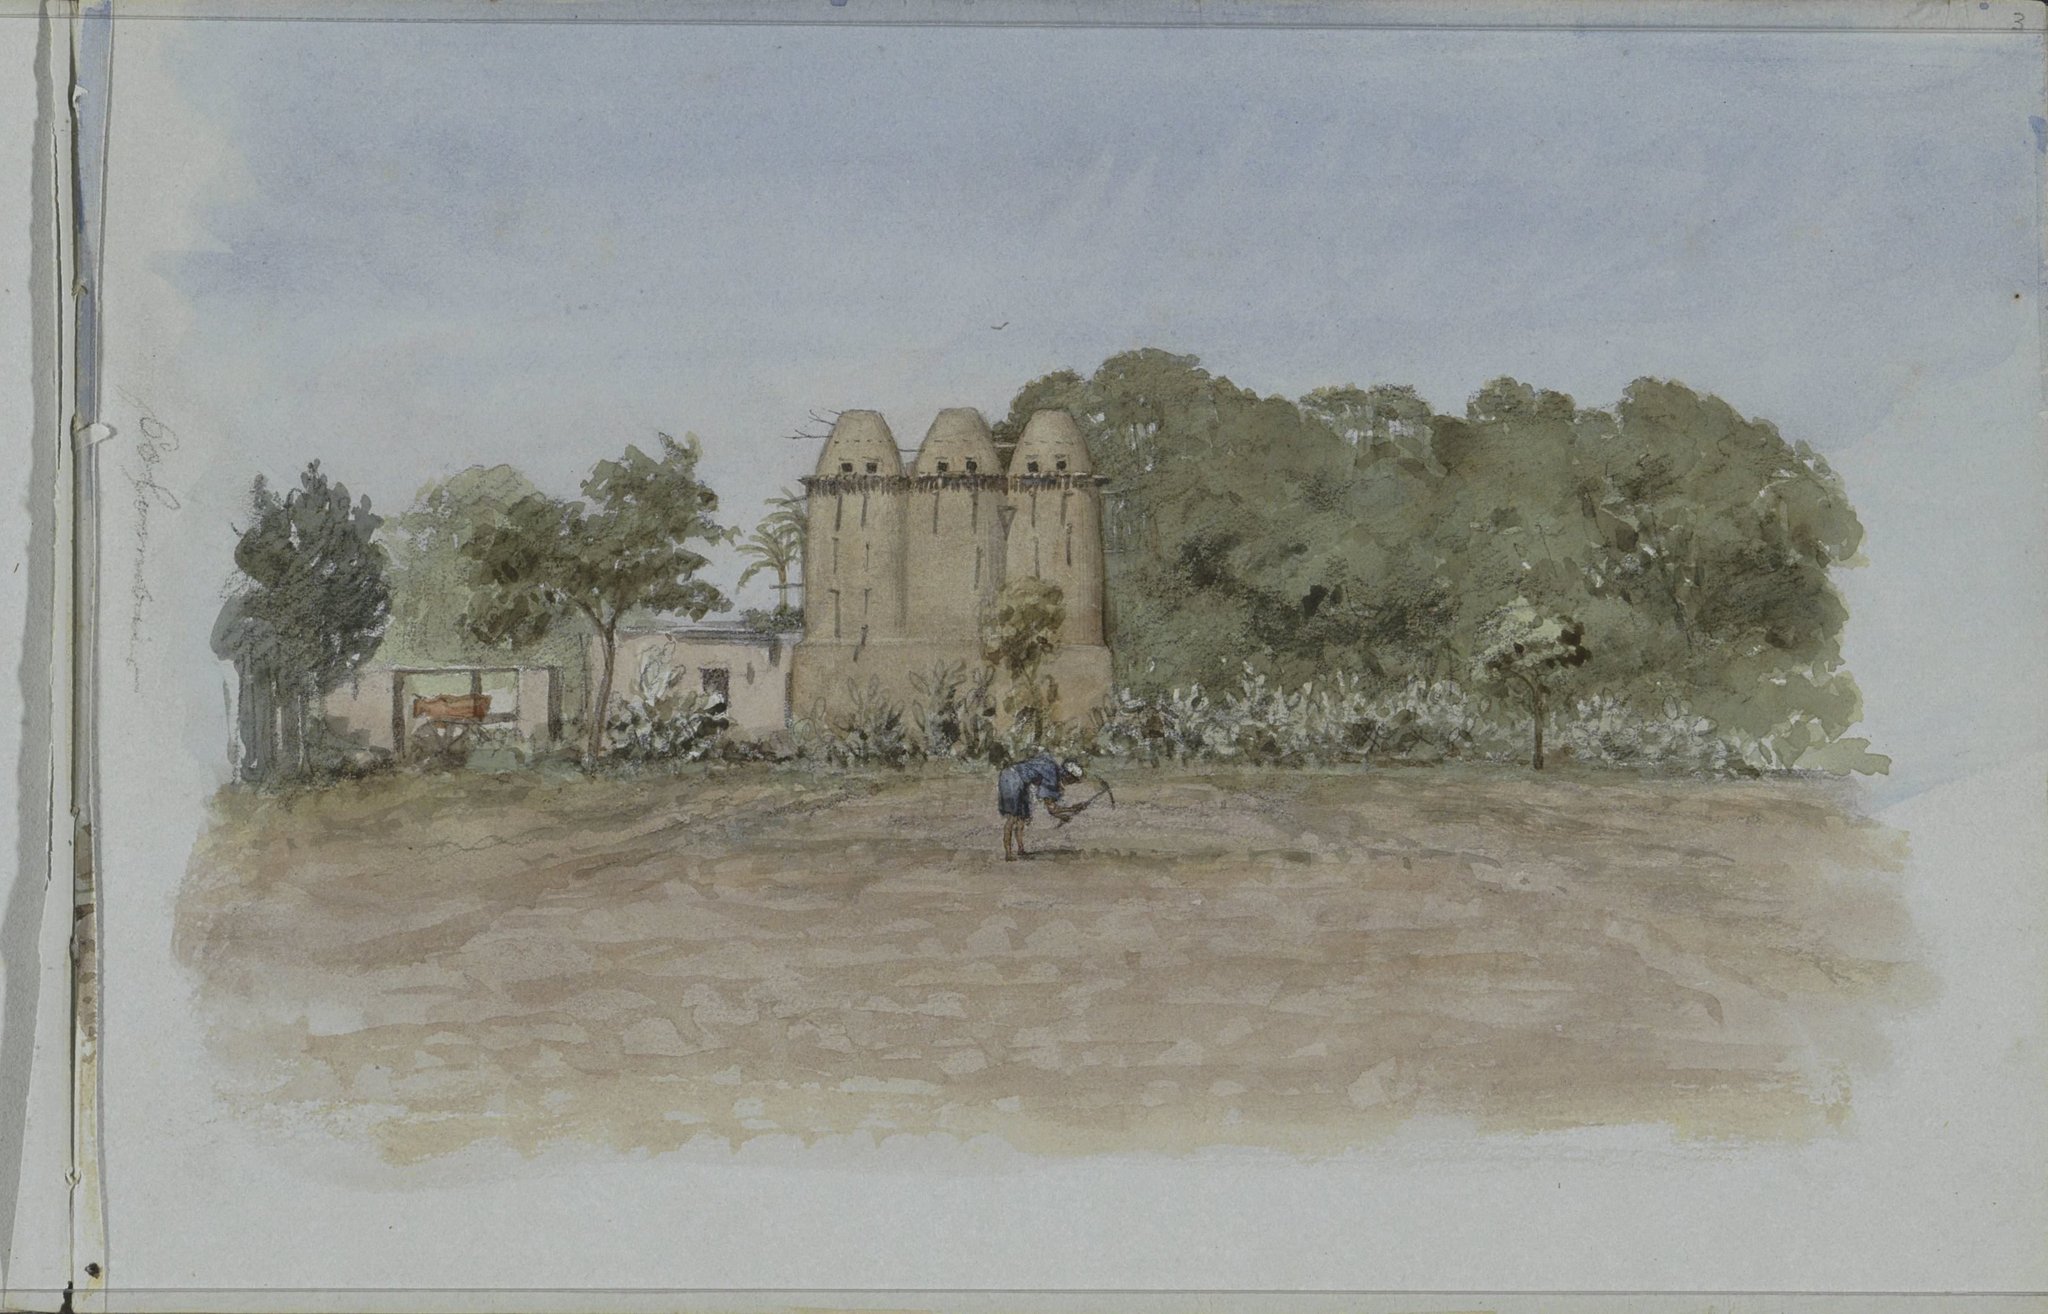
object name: sketchbook leaf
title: Duiventorens bij een stuk landbouwgrond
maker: willem de famars testas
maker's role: draughtsman, painter, print maker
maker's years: 1834-1896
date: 1858-1860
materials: paper, pencil, watercolor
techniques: brush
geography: egypt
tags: soil cultivation, tower (of house or building)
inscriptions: annotation: ‘[...]’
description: Op het land werkt een man. Blad 3 recto uit een schetsboek met 23 bladen.